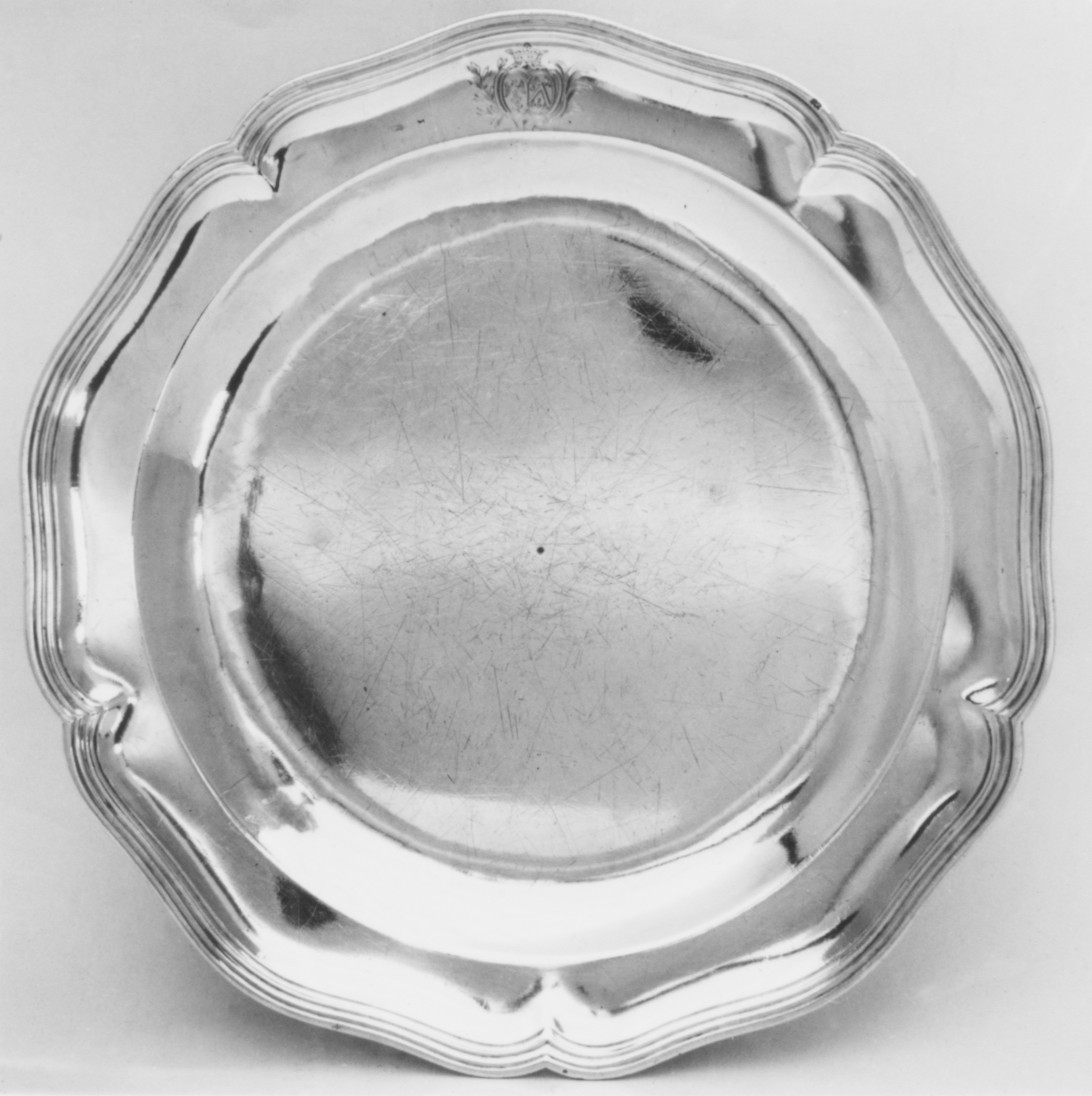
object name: plate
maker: charles duchesne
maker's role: maker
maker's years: 1708-1753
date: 1746-1747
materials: silver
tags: coat of arms